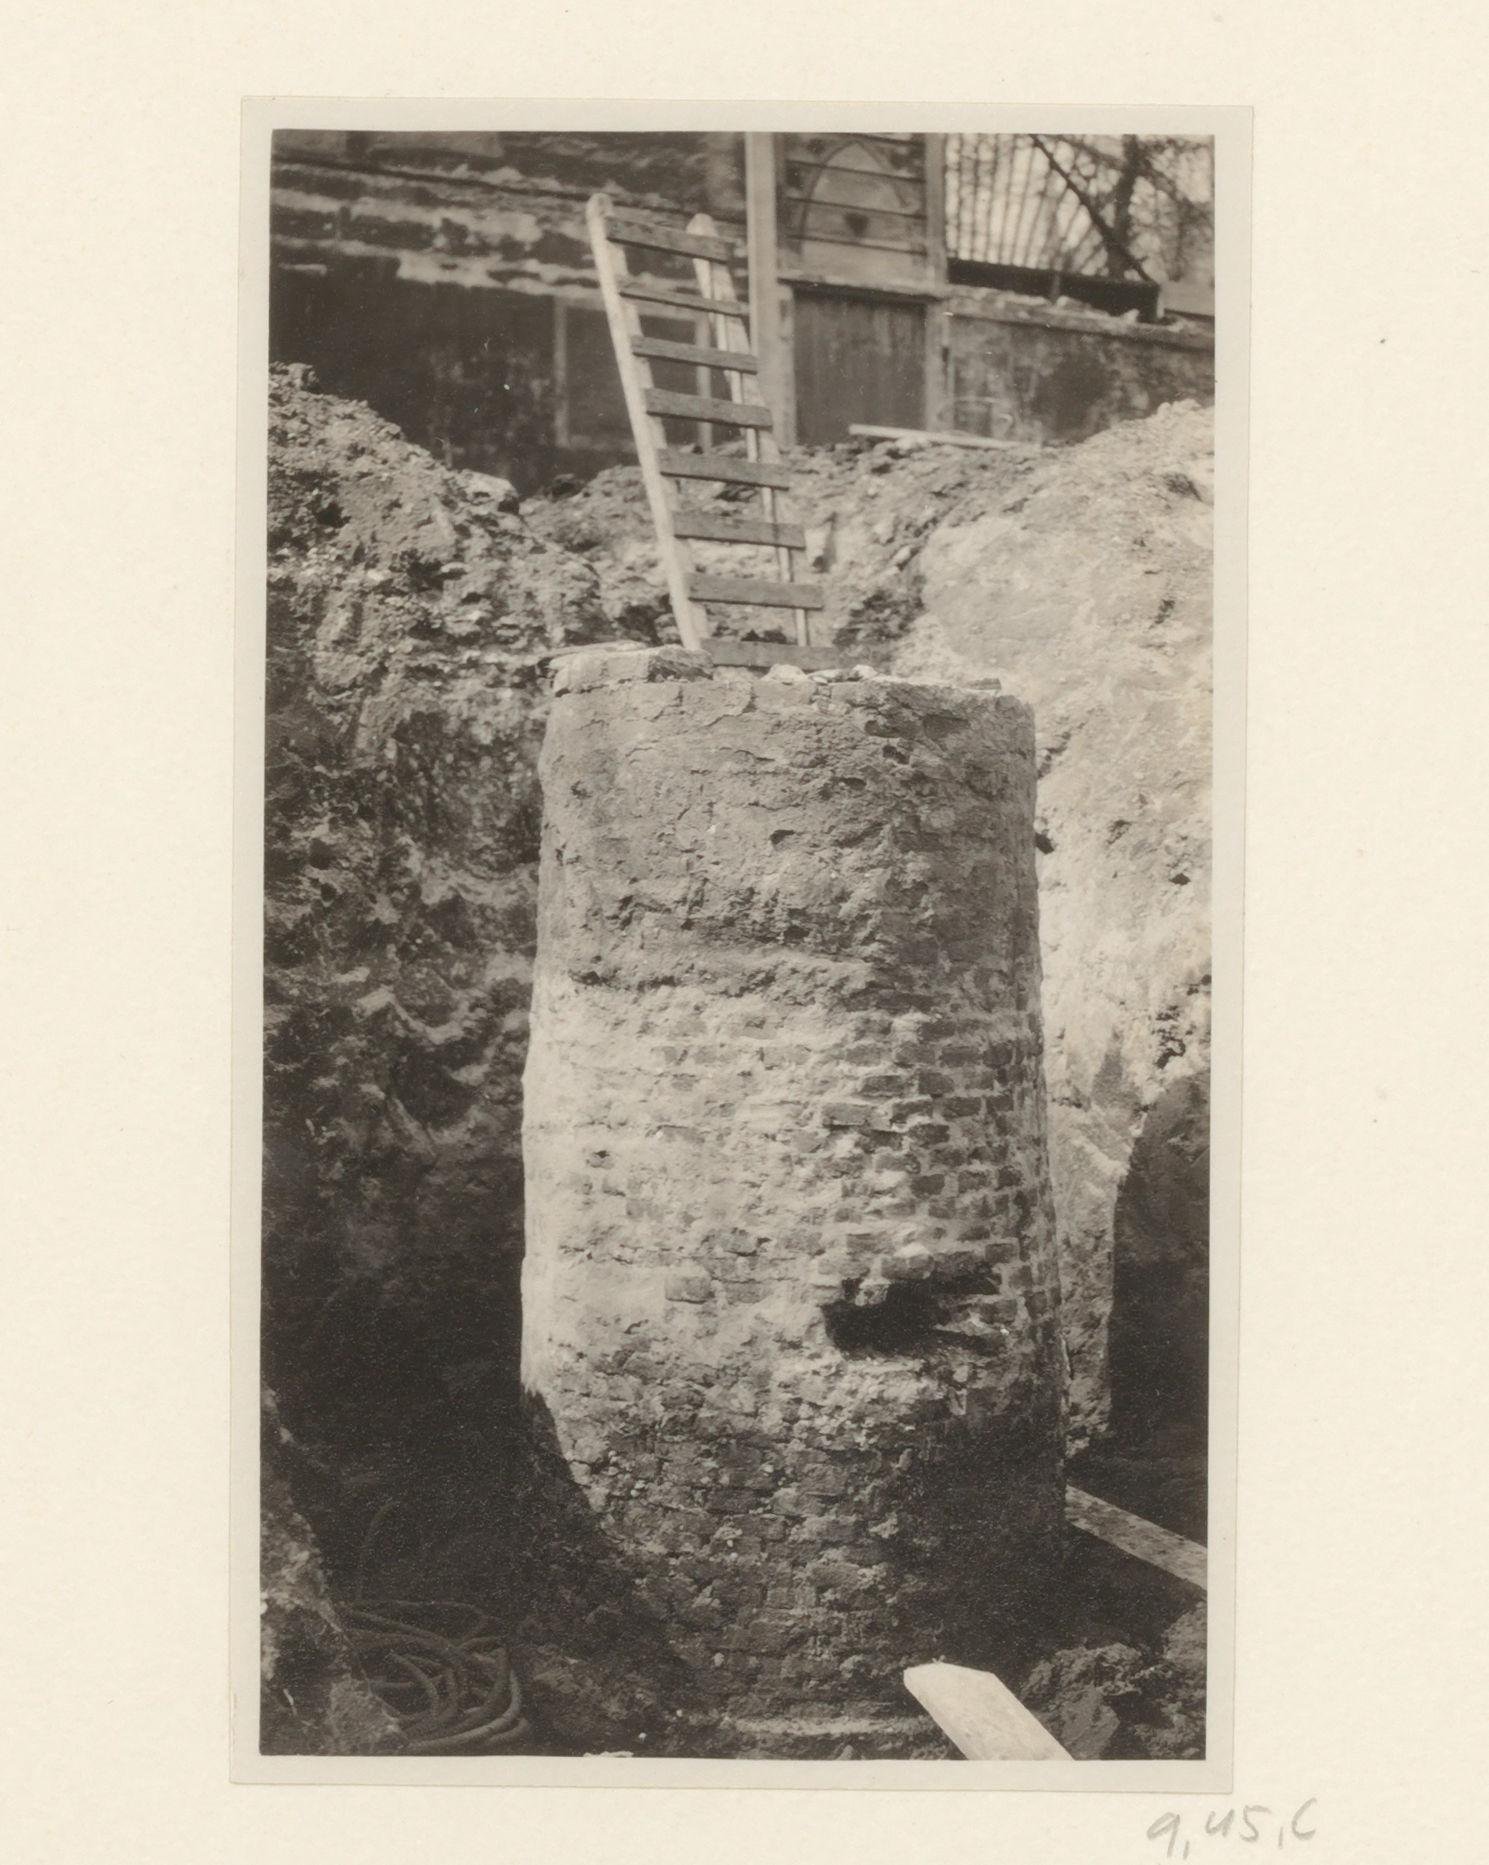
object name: photograph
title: Gezicht op mogelijk een waterput, ontdekt op Keizersgracht 418-424 tijdens verbouwingen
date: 1930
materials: paper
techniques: gelatin silver print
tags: well, city-view in general; 'veduta', building-site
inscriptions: inscription: ‘Bouwfragmenten / Keizersgracht 418-424 / Ao 1930 / Koelput ? / Waterput ? / vEck’, collector's mark: ‘9,45 A-C’ Lugt 1641b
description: Onderwerpsrubriek binnen de Atlas Amsterdam: Kadijksplein, Karthuizerkerkhof, Kattegat, Kattenburg, Kapelsteeg O.Z., Enge Kerksteeg, Kerkstraat, Kinkerstraat, Kolk O.Z., Koningsplein, Kromboomsloot [Krom Boomssloot], Kostverlorenkade, Kwakersdwarspad, Kalverstraat, Keizersgracht (v.d. Brouwersgracht – Amstel), Klerensloot (Gedempte), Klimopstraat, Kloveniersburgwal, Kraansluis.